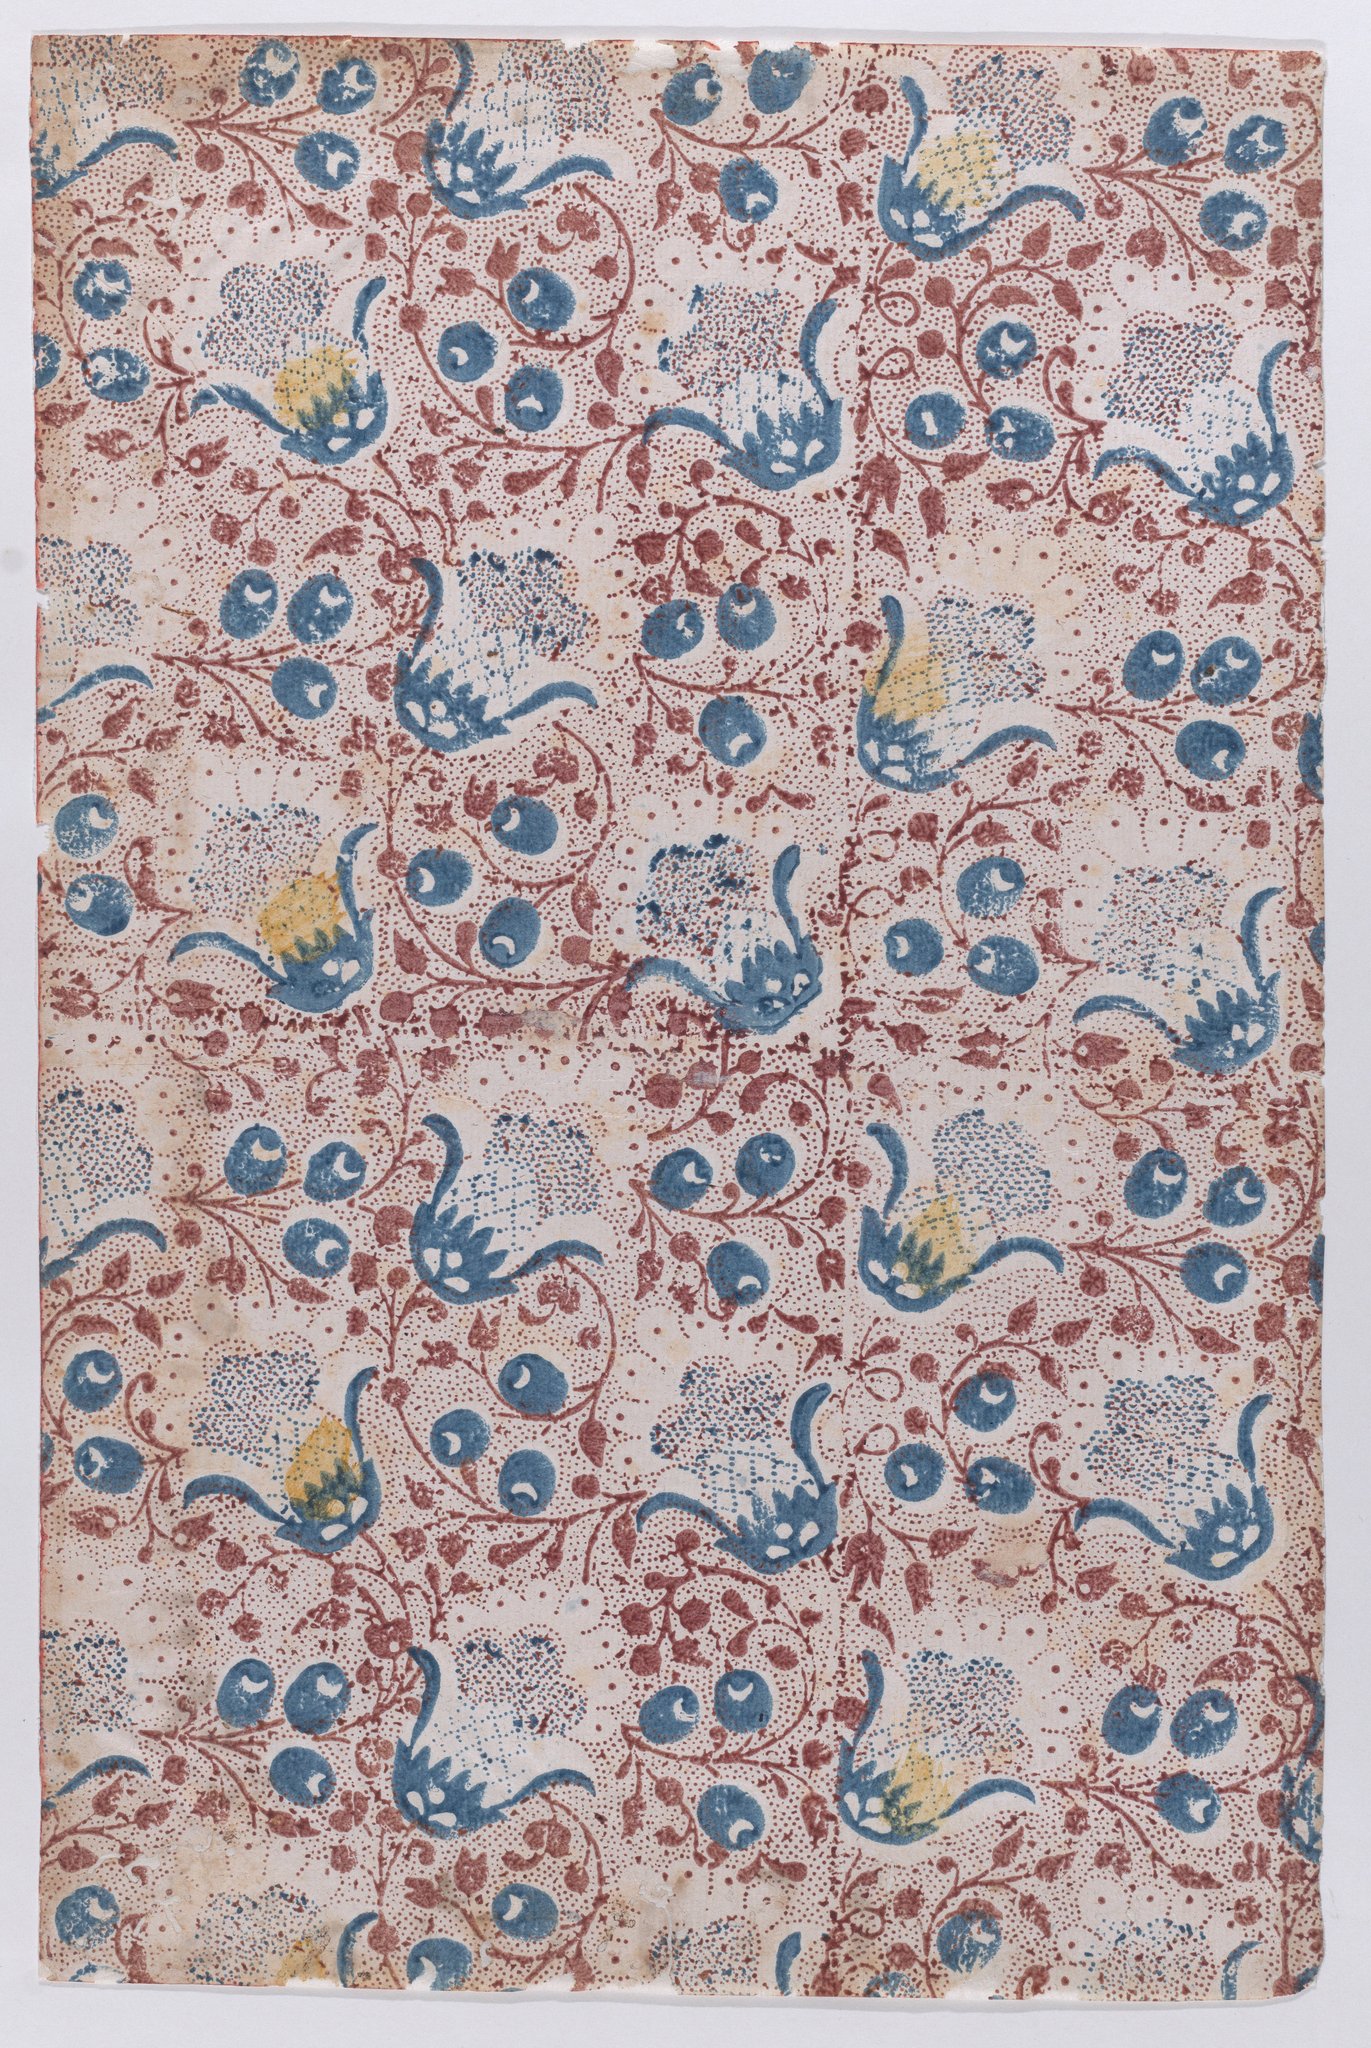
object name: print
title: Sheet with overall dot, floral, and vine pattern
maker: Anonymous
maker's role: artist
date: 1801-1900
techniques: relief print